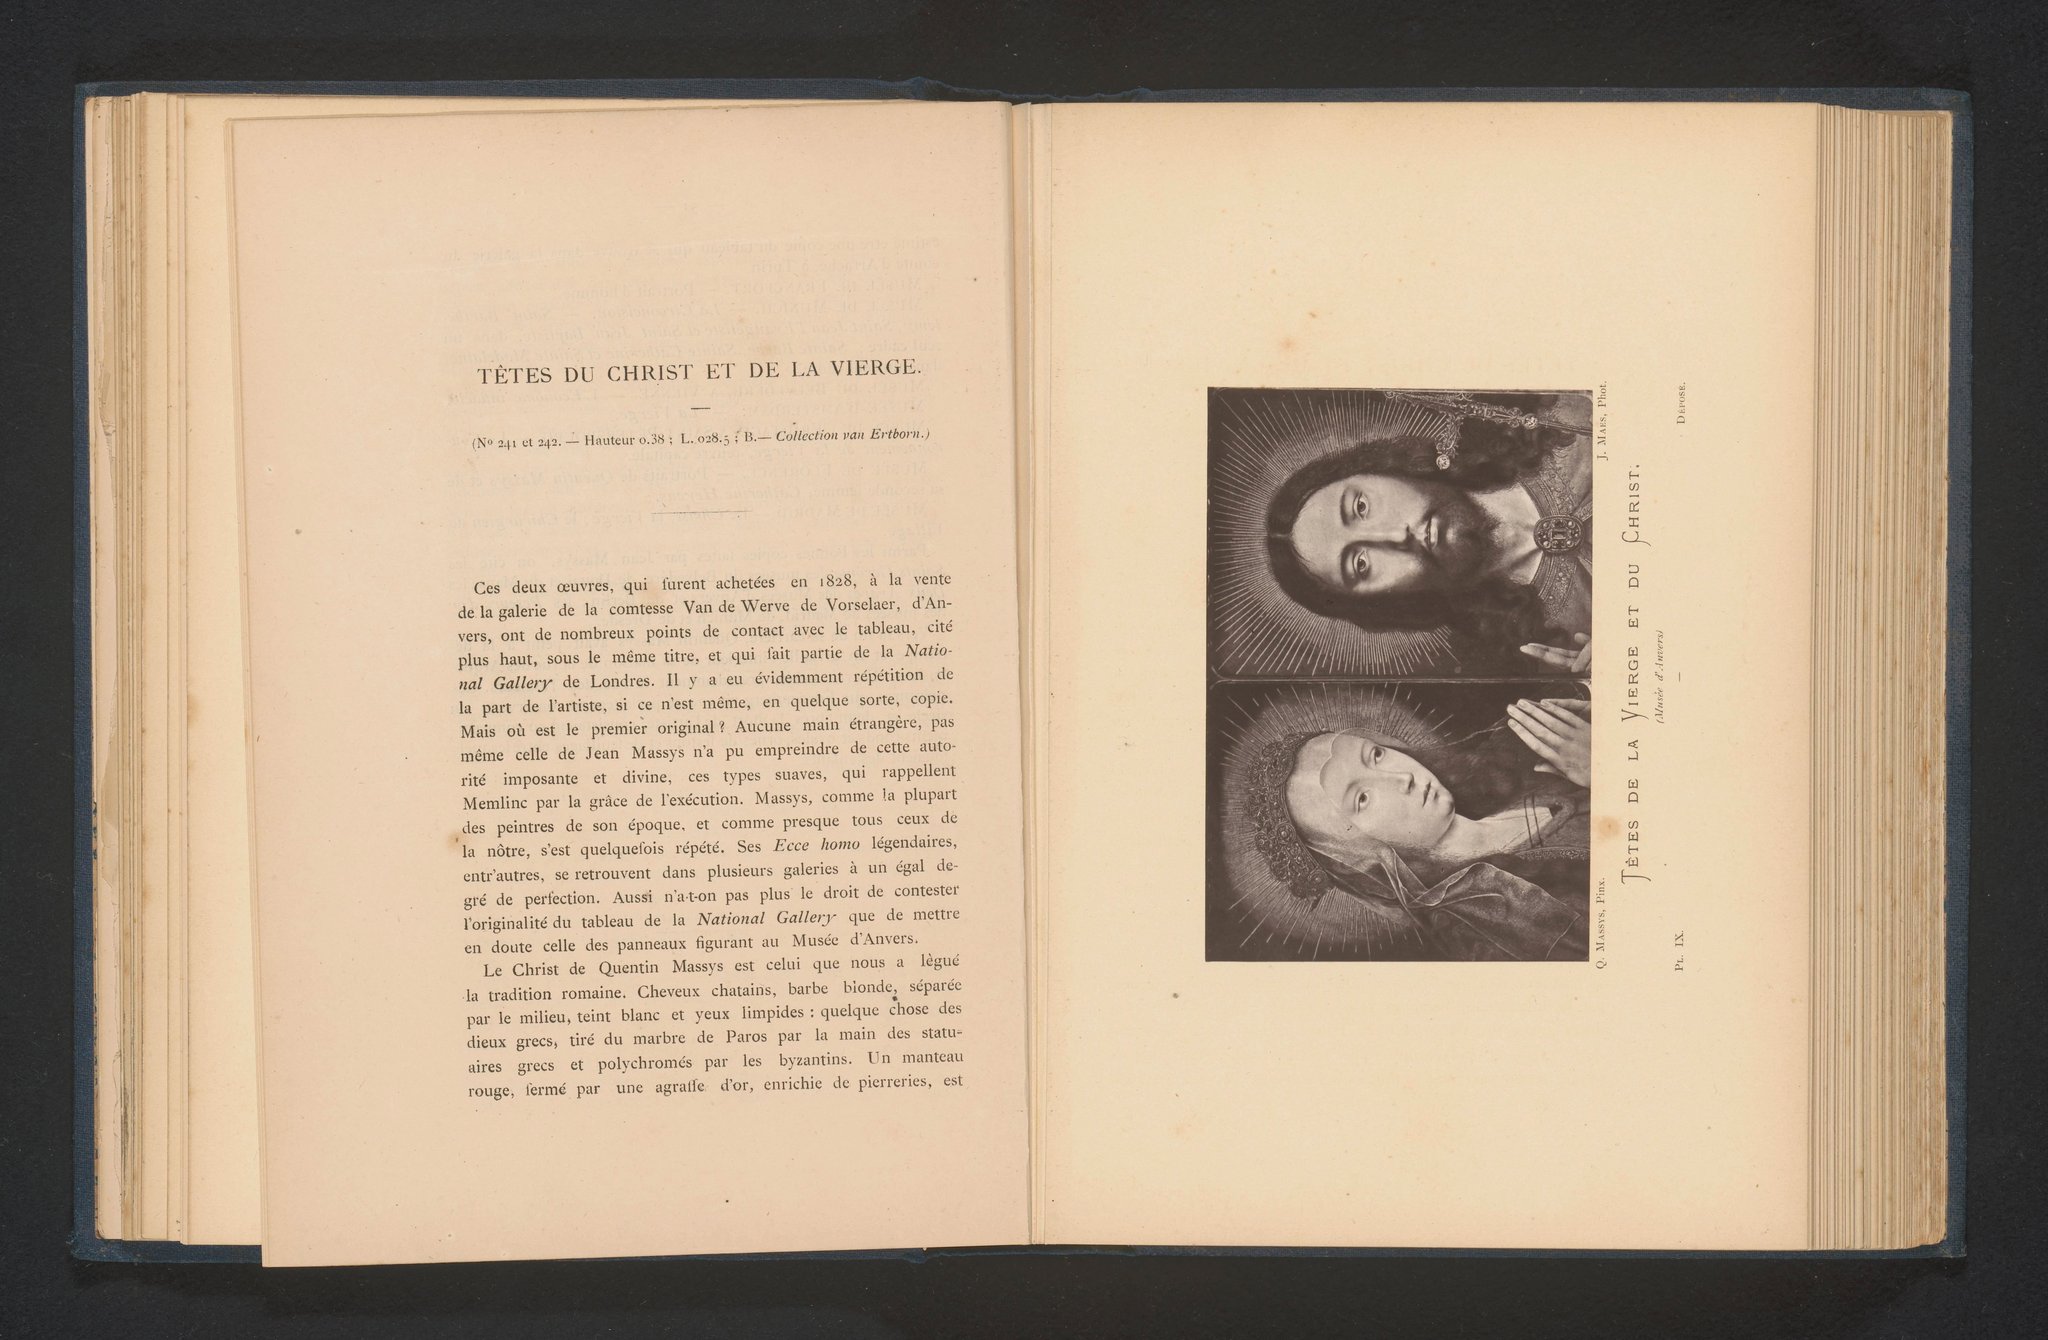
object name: reproduction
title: Têtes de la Vierge et du Christ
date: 1872-1877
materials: paper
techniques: woodburytype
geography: antwerp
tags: 'portraits' of mary, 'portraits' of christ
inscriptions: inscription: ‘(Musée d'Anvers)/ Pl. IX. Déposé.’